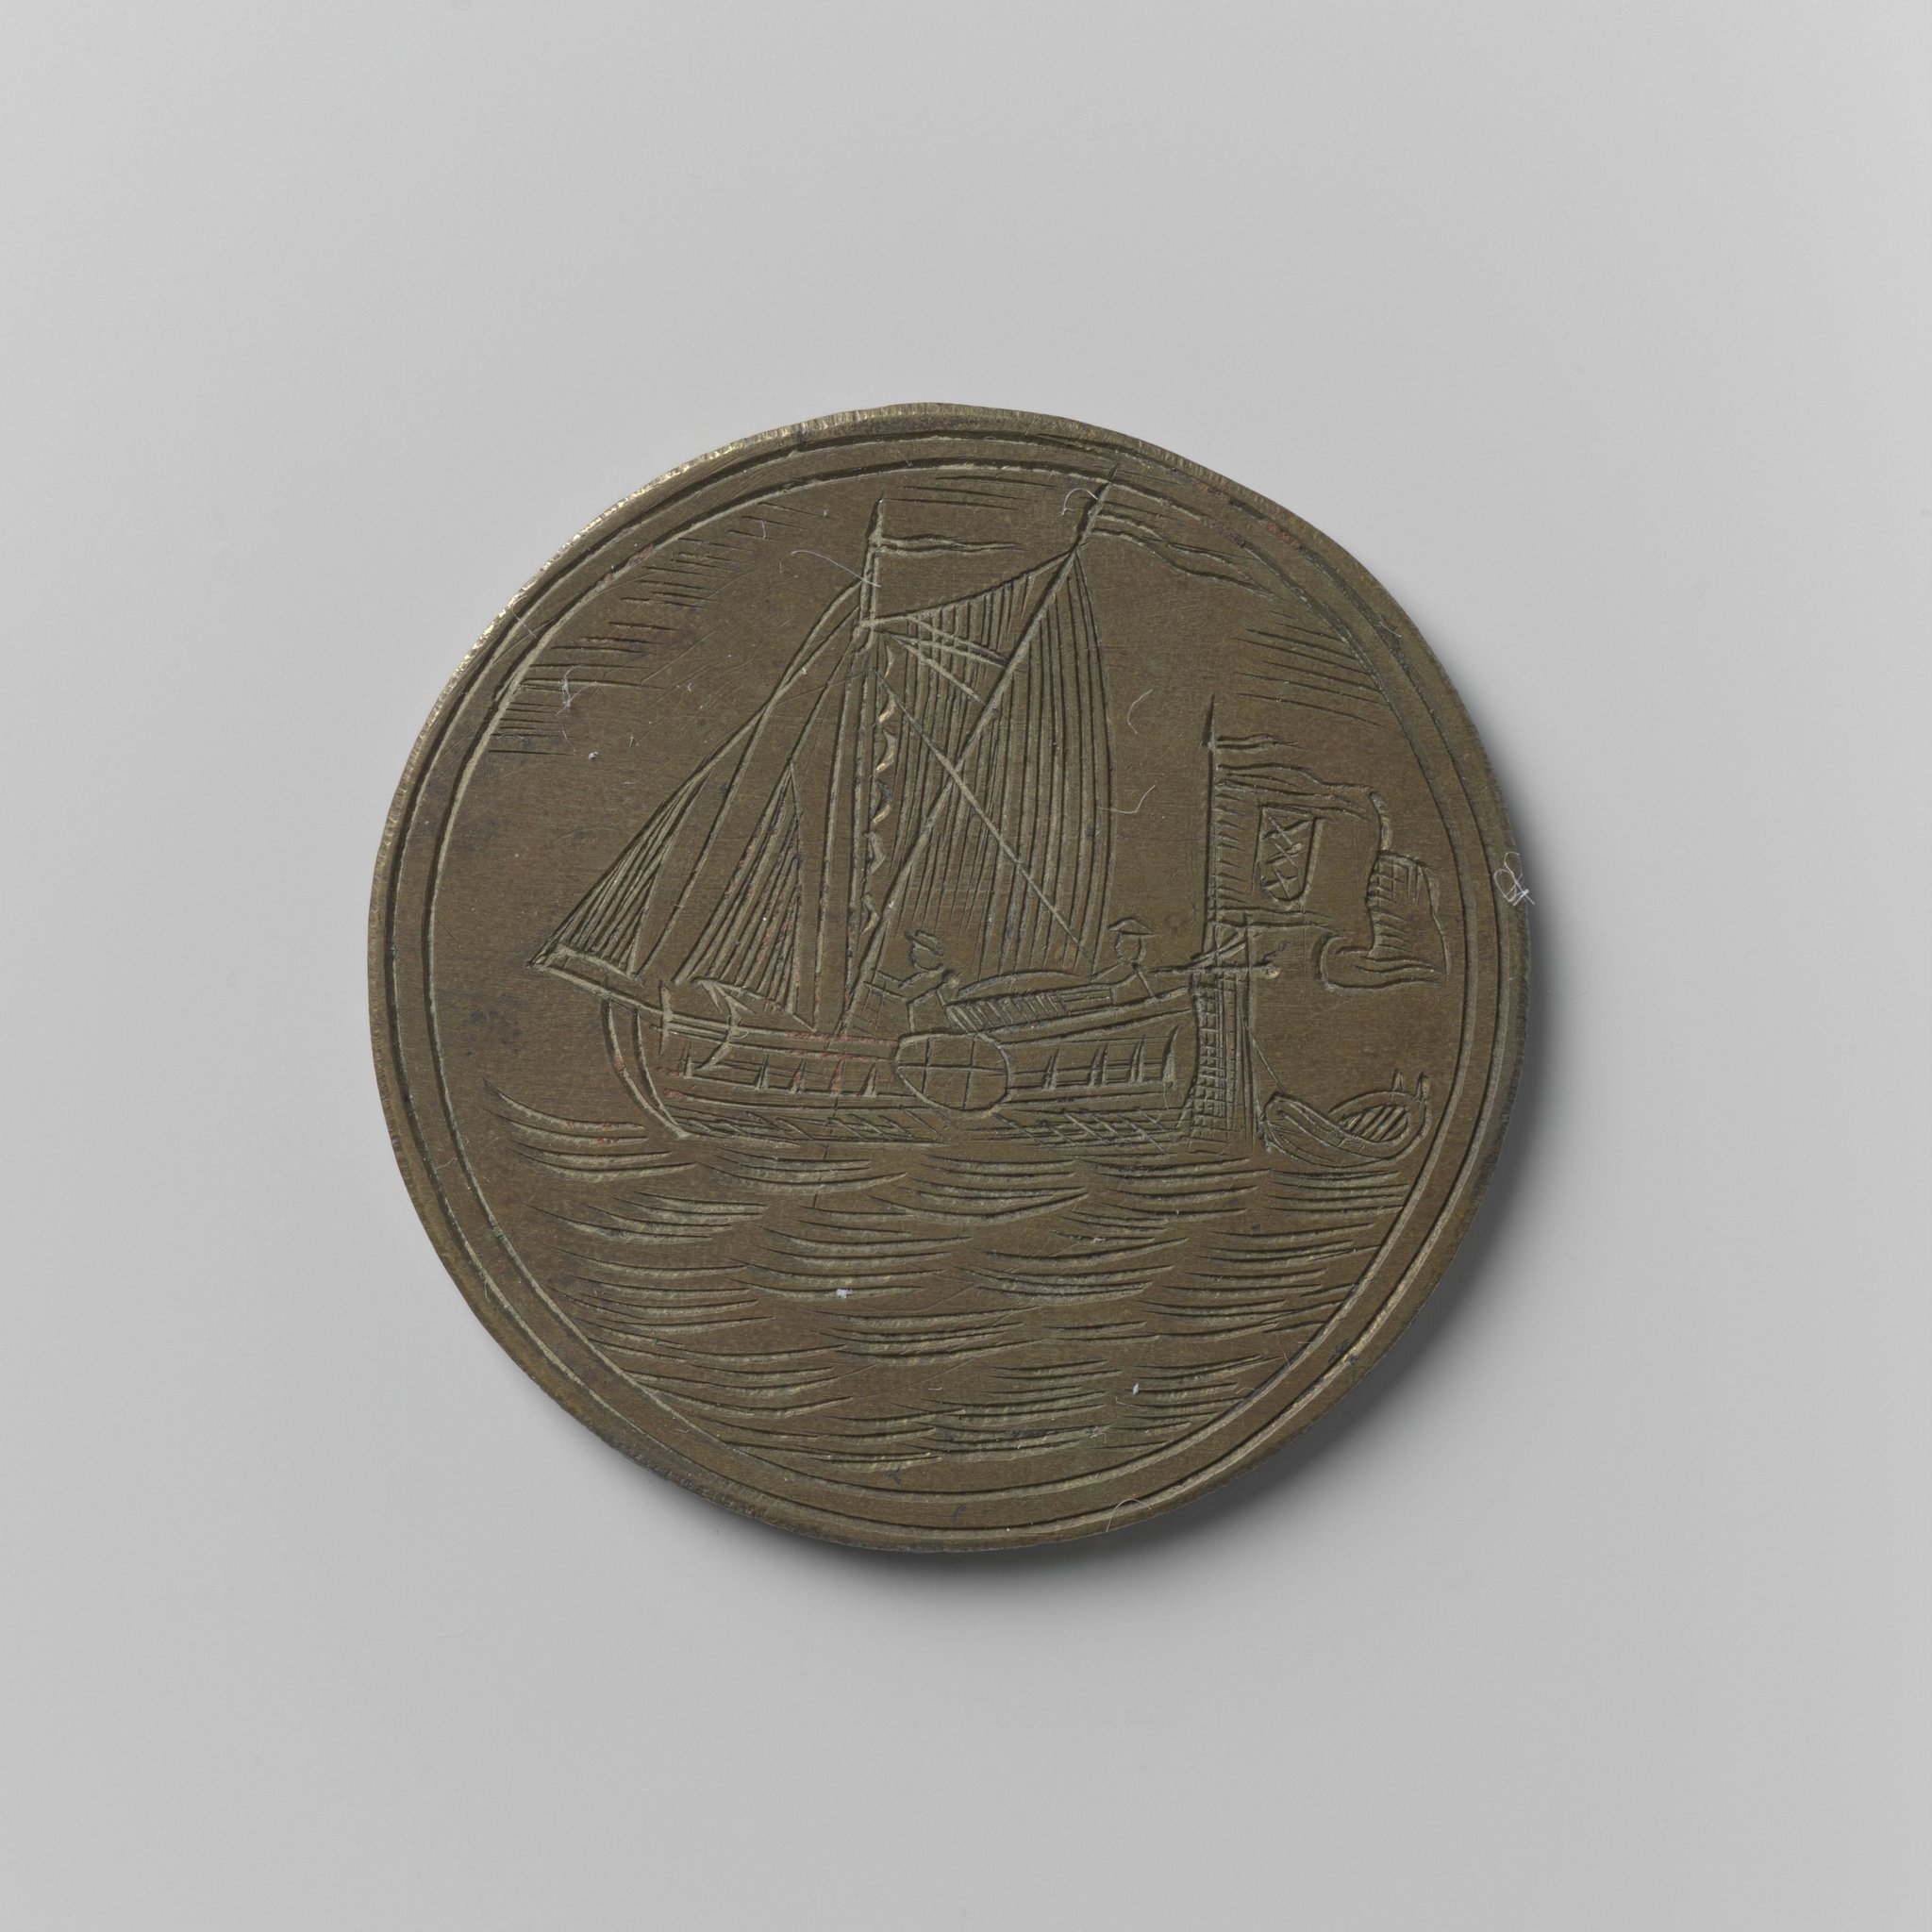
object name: medal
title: Groot binnen- en buitenlandsvaardersgilde van Amsterdam, gildepenning van Jan Hendrik Smeenk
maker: Anonymous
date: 1730-1783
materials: brass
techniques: engraving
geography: amsterdam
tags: amsterdam